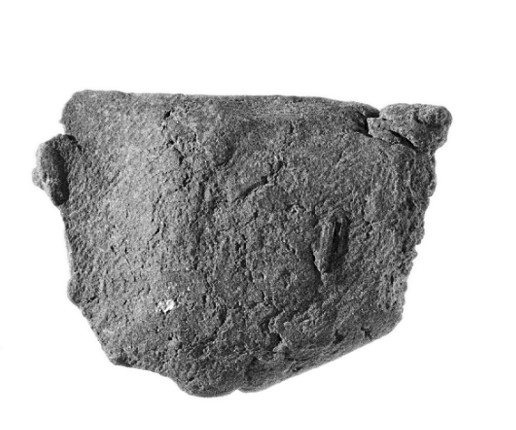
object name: sealing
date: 1981-1640 BCE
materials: mud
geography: egypt